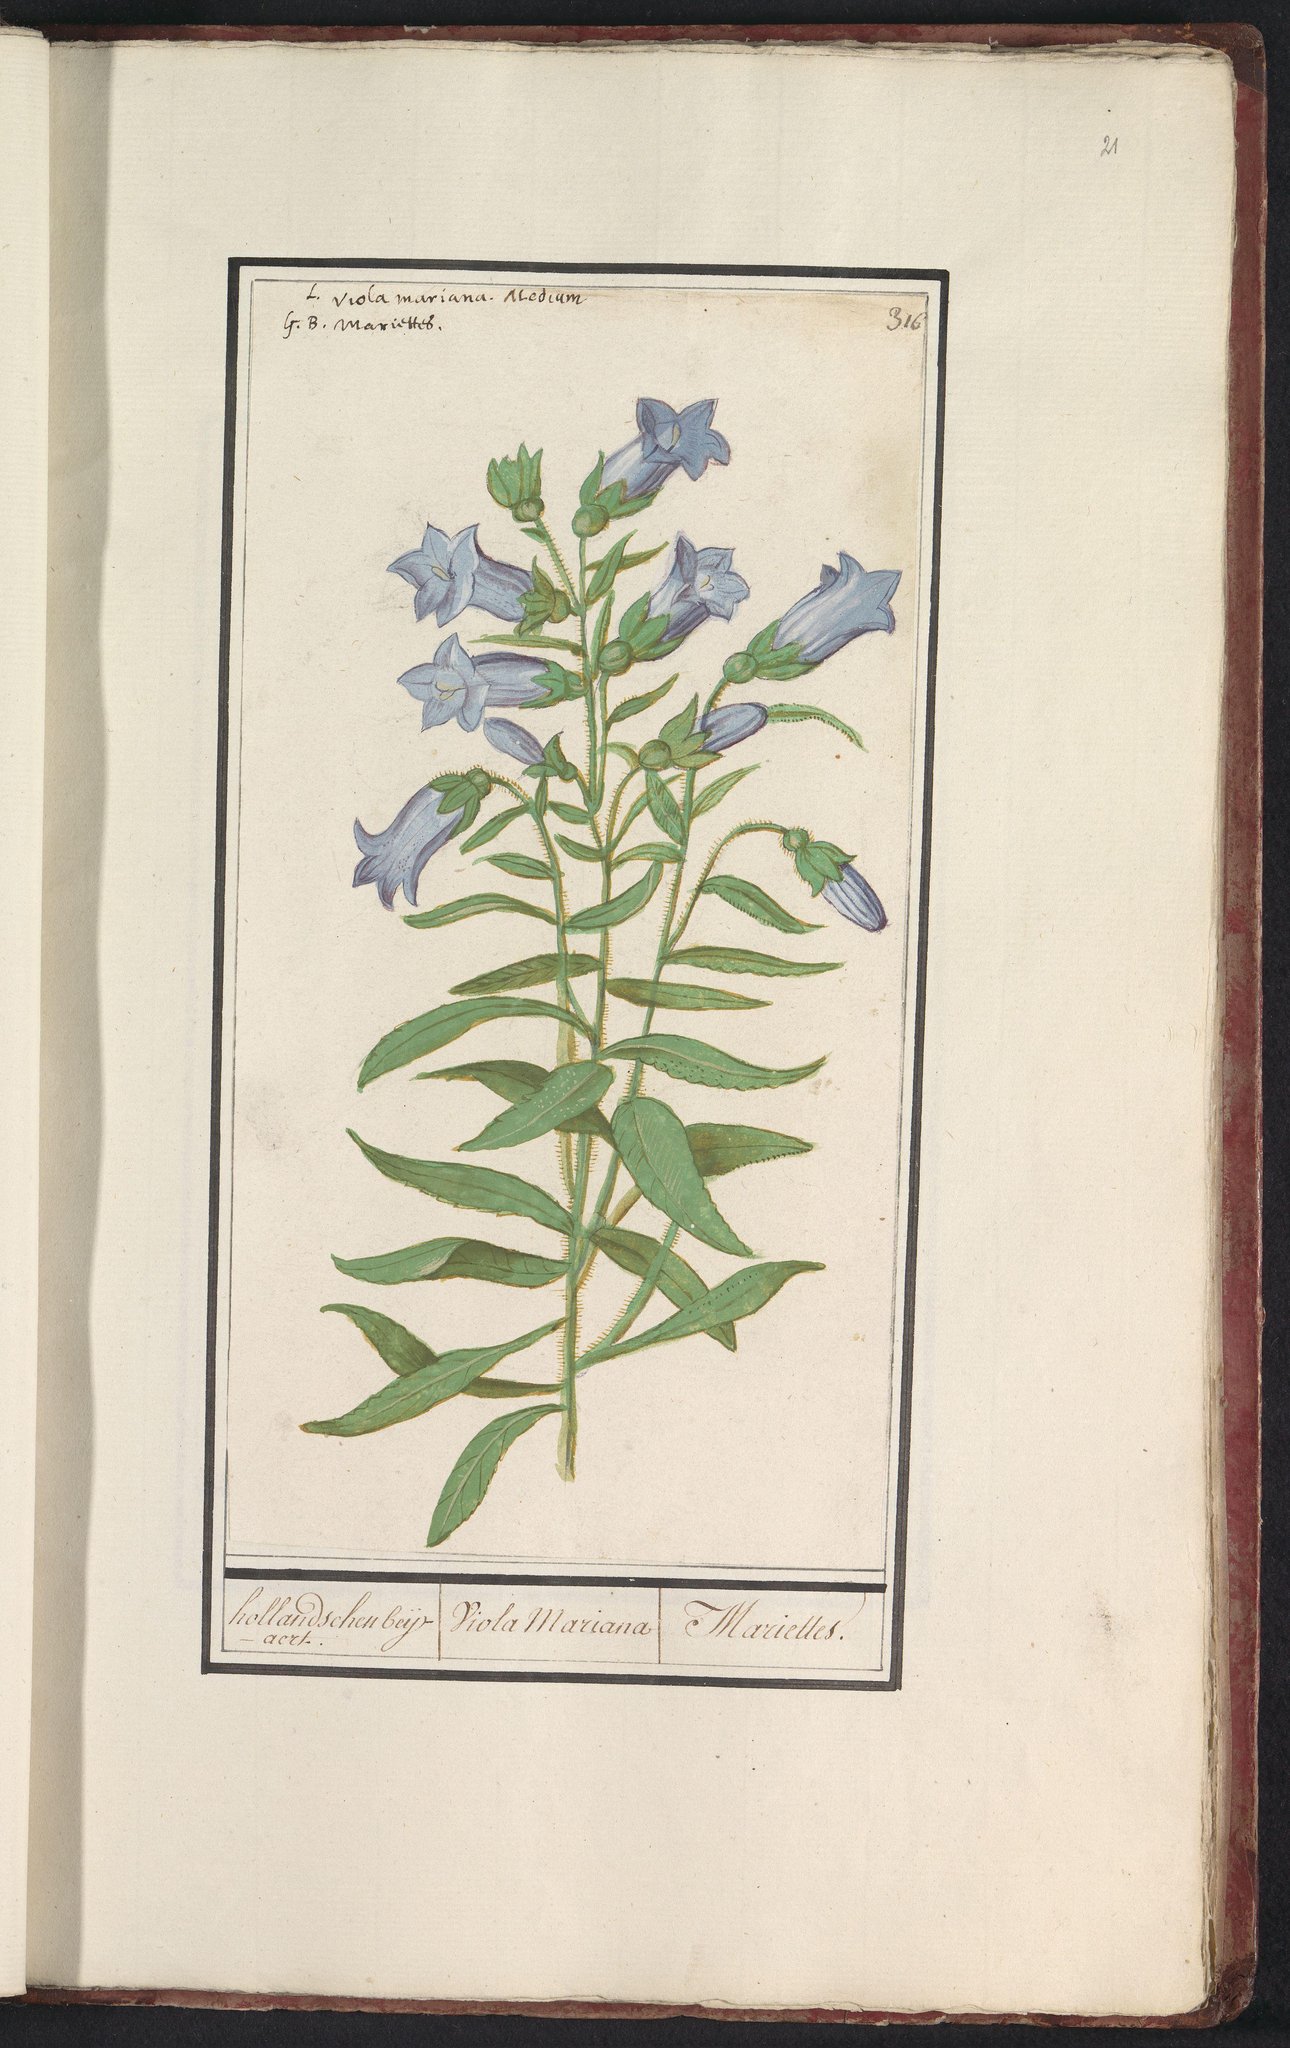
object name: drawing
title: hollandschen beijaert. / Viola Mariana Marielles.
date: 1596-1610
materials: chalk, paint, ink, paper, watercolor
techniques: brush, pen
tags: flowers: gentiana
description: Klokjesgentiaan. Genummerd rechtsboven: 316. Linksboven de Latijnse en Franse naam. Onderdeel van het vierde album met tekeningen van bloemen en paddestoelen. Elfde van twaalf albums met tekeningen van dieren, vogels en planten bekend rond 1600, gemaakt in opdracht van keizer Rudolf II. Met toelichting in Nederlands, Latijn en Frans.